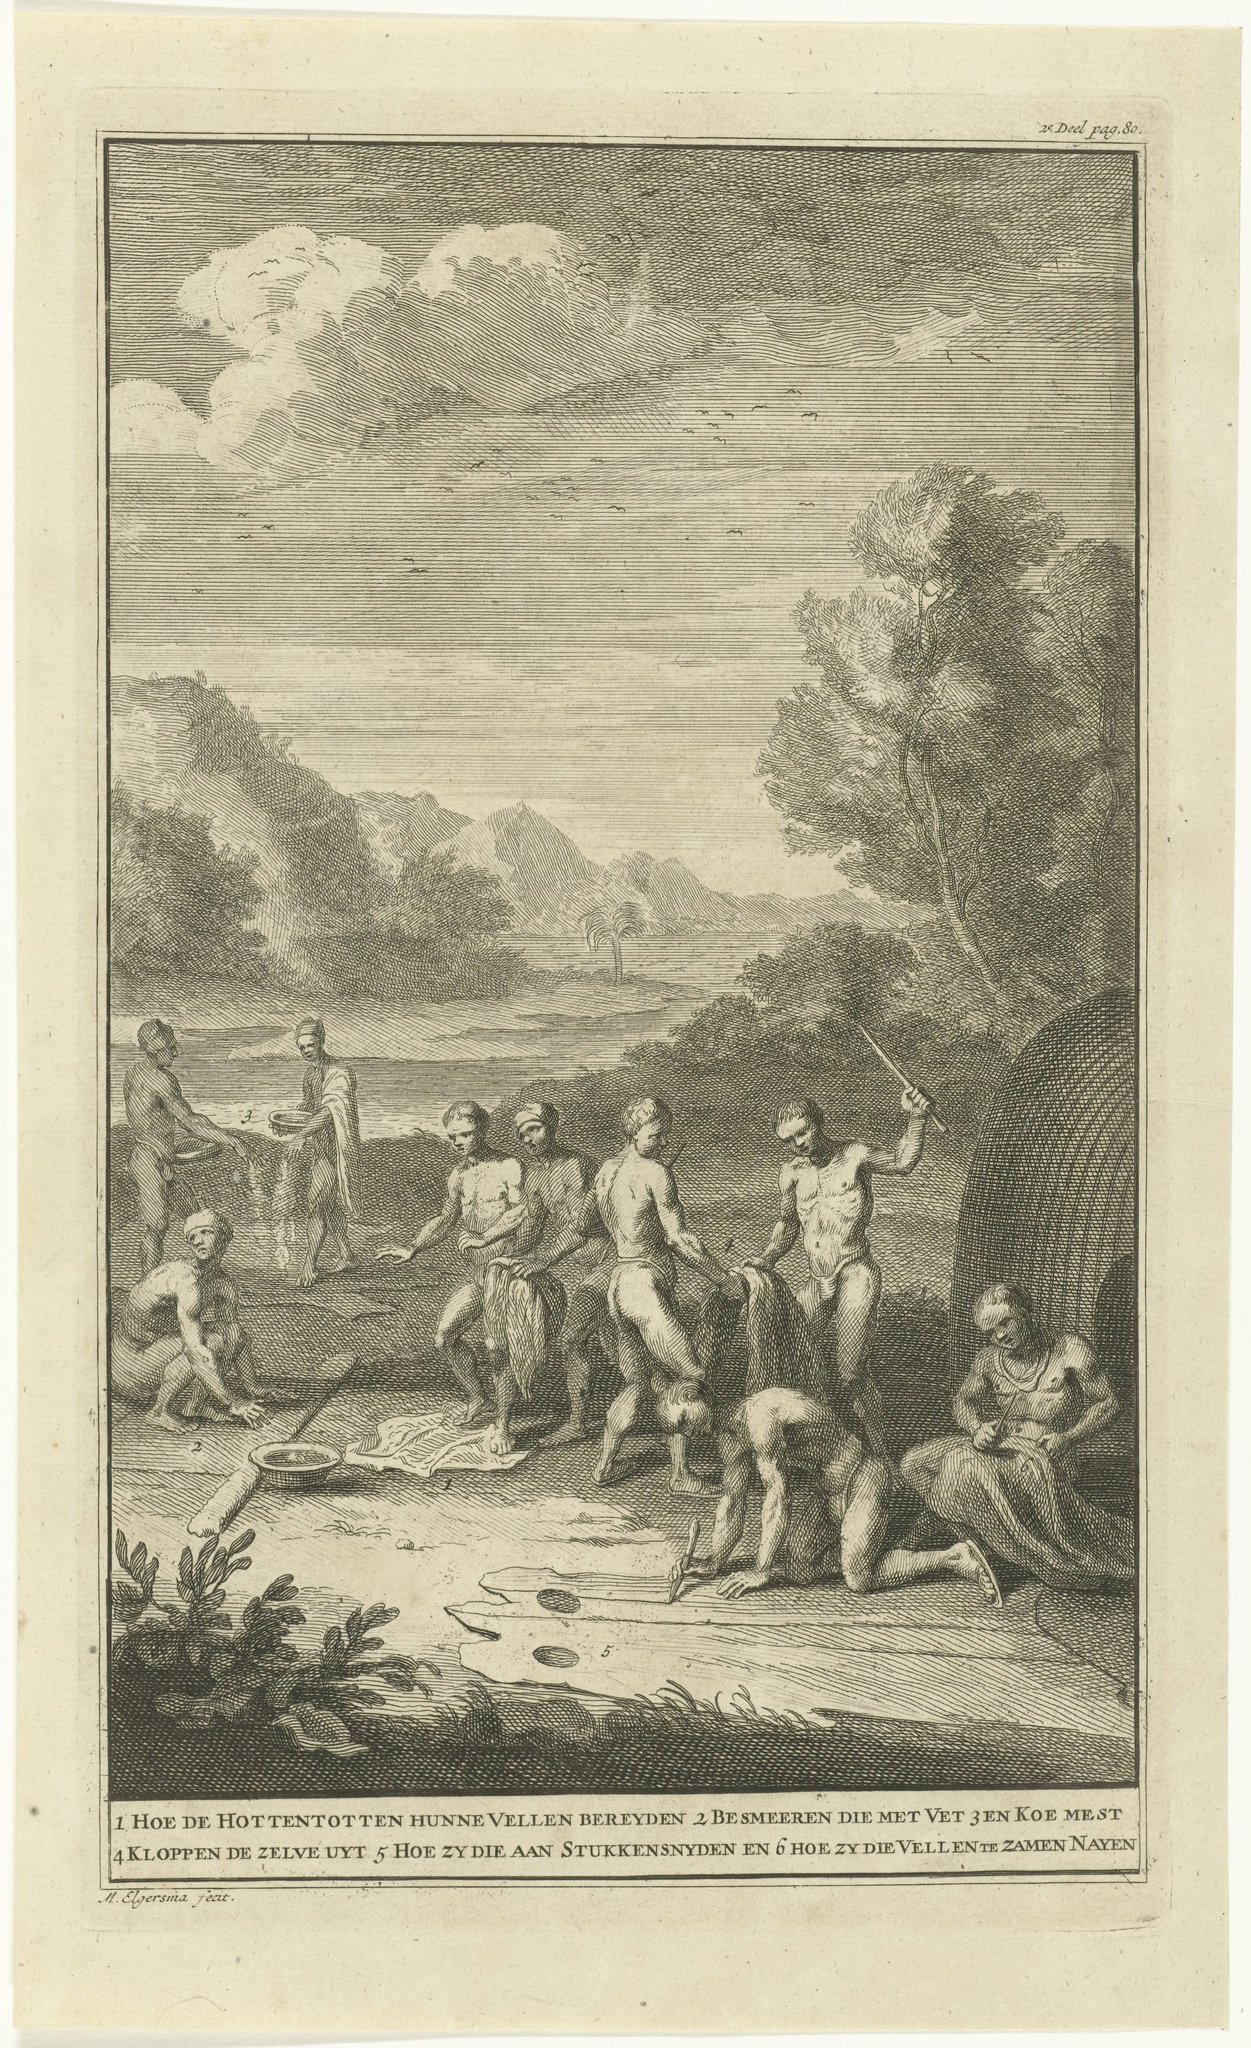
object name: book illustration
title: Leerlooiende Khoikhoi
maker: michiel elgersma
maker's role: print maker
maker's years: 1690-1759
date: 1727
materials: paper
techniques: etching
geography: netherlands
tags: khoikhoi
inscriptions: collector's mark: Lugt 2228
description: In een landschap met bergen op de achtergrond, zijn negen mannen in de weer met verschillende stadia van het prepareren van huiden. Onder de voorstelling wordt de werkwijze in zes stappen uitgelegd; van het voorbereiden van de huiden tot het aan elkaar naaien ervan.